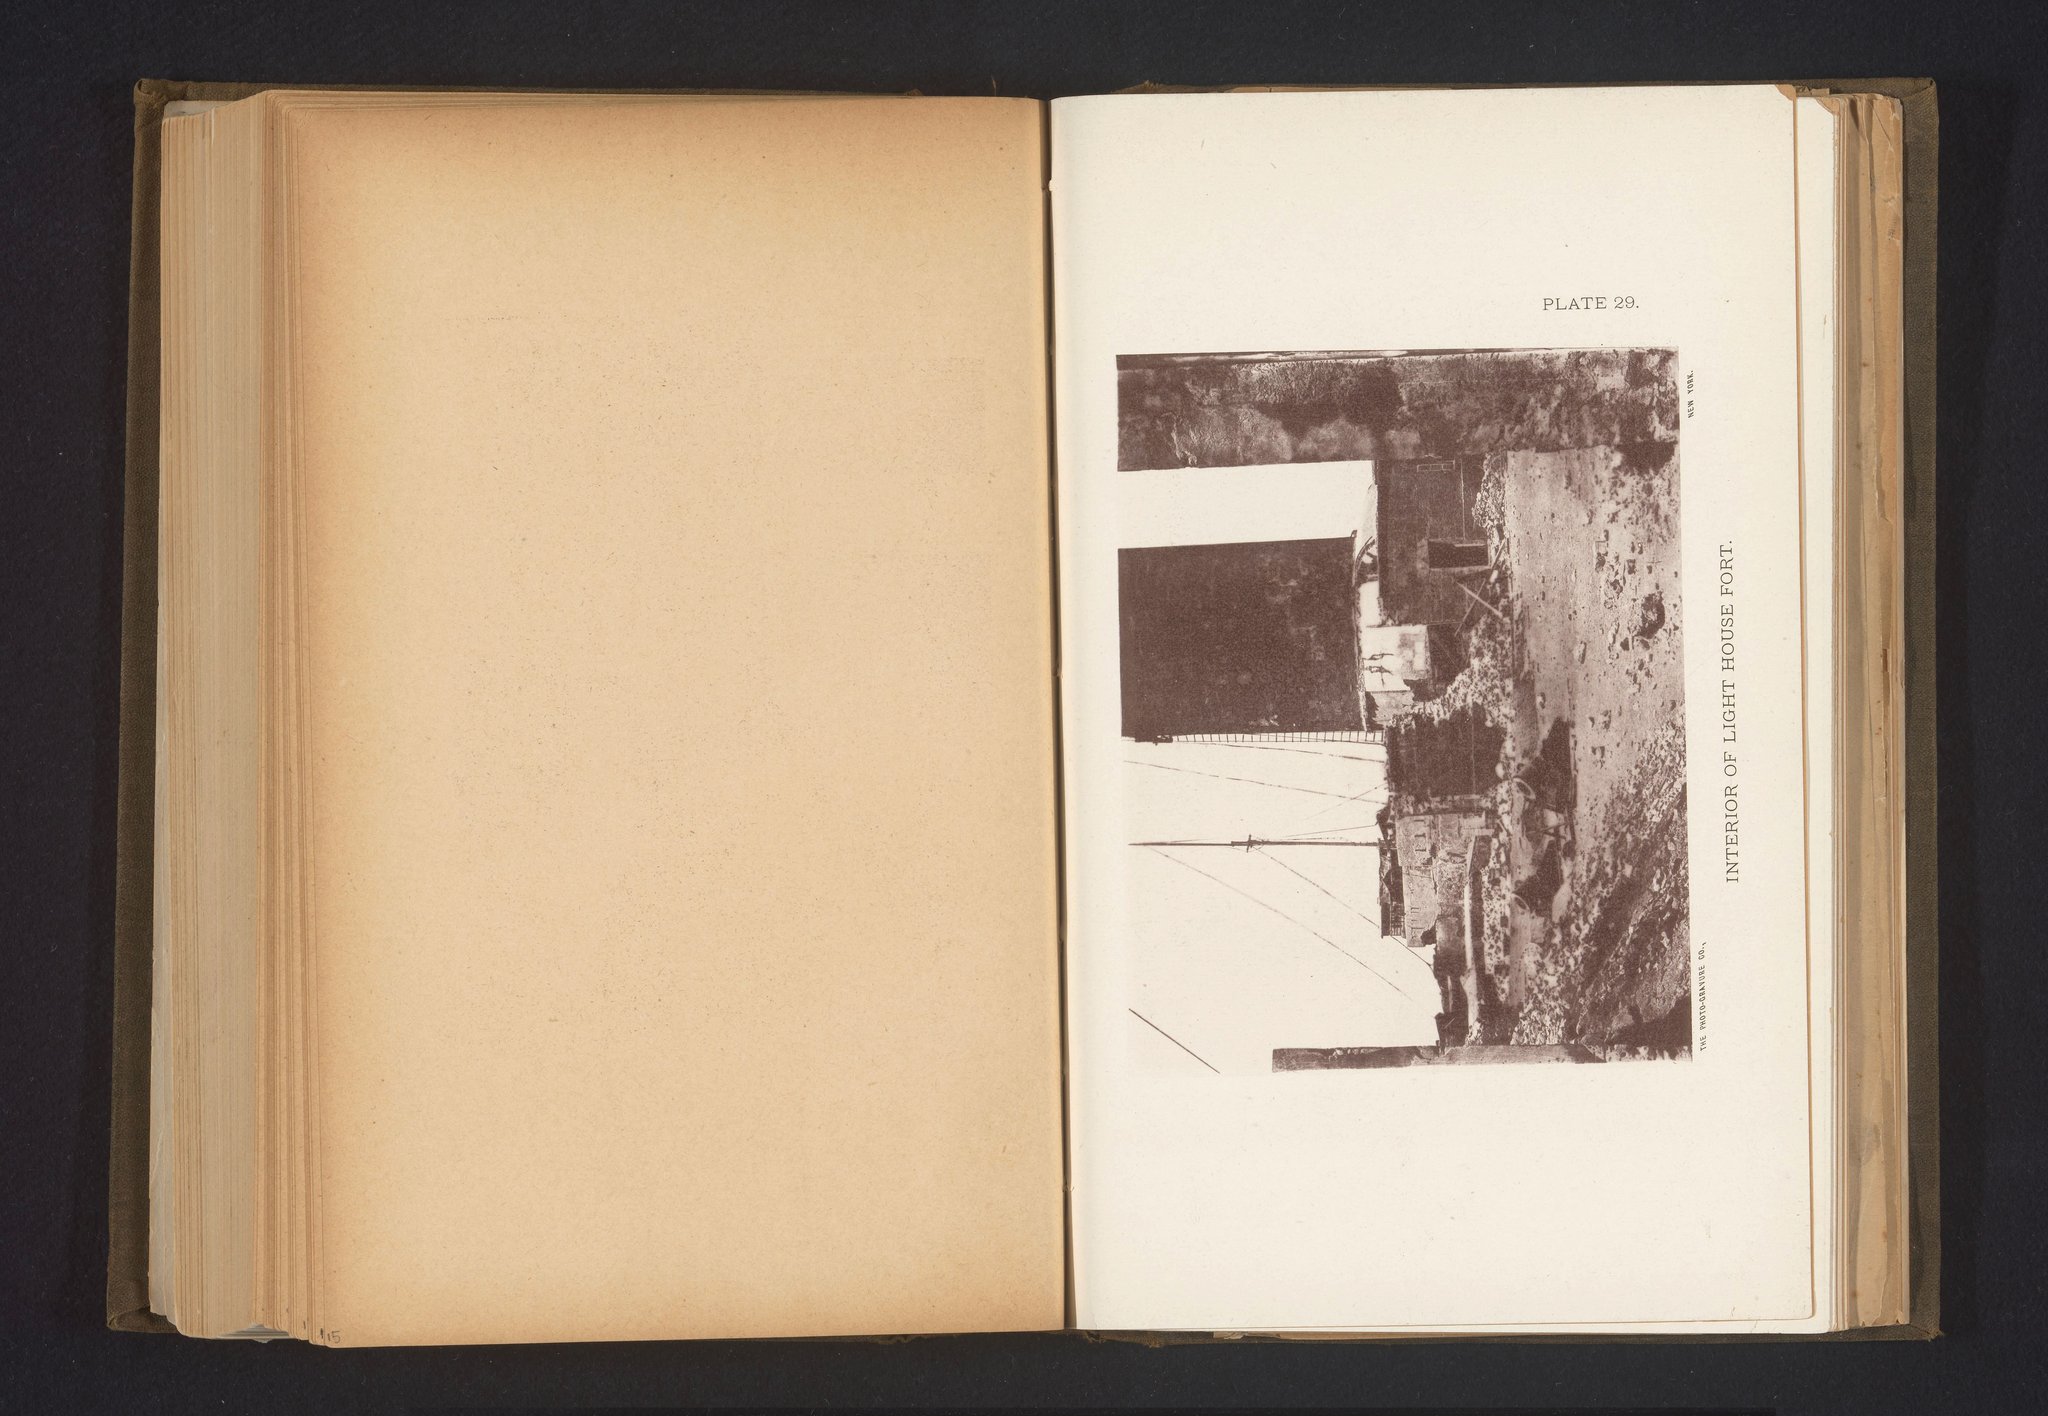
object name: photomechanical print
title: Interieur van een fort in Alexandrië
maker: Anonymous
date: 1882-1885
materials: paper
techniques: photograph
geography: new york city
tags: fortress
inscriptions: number: ‘Plate 29.’